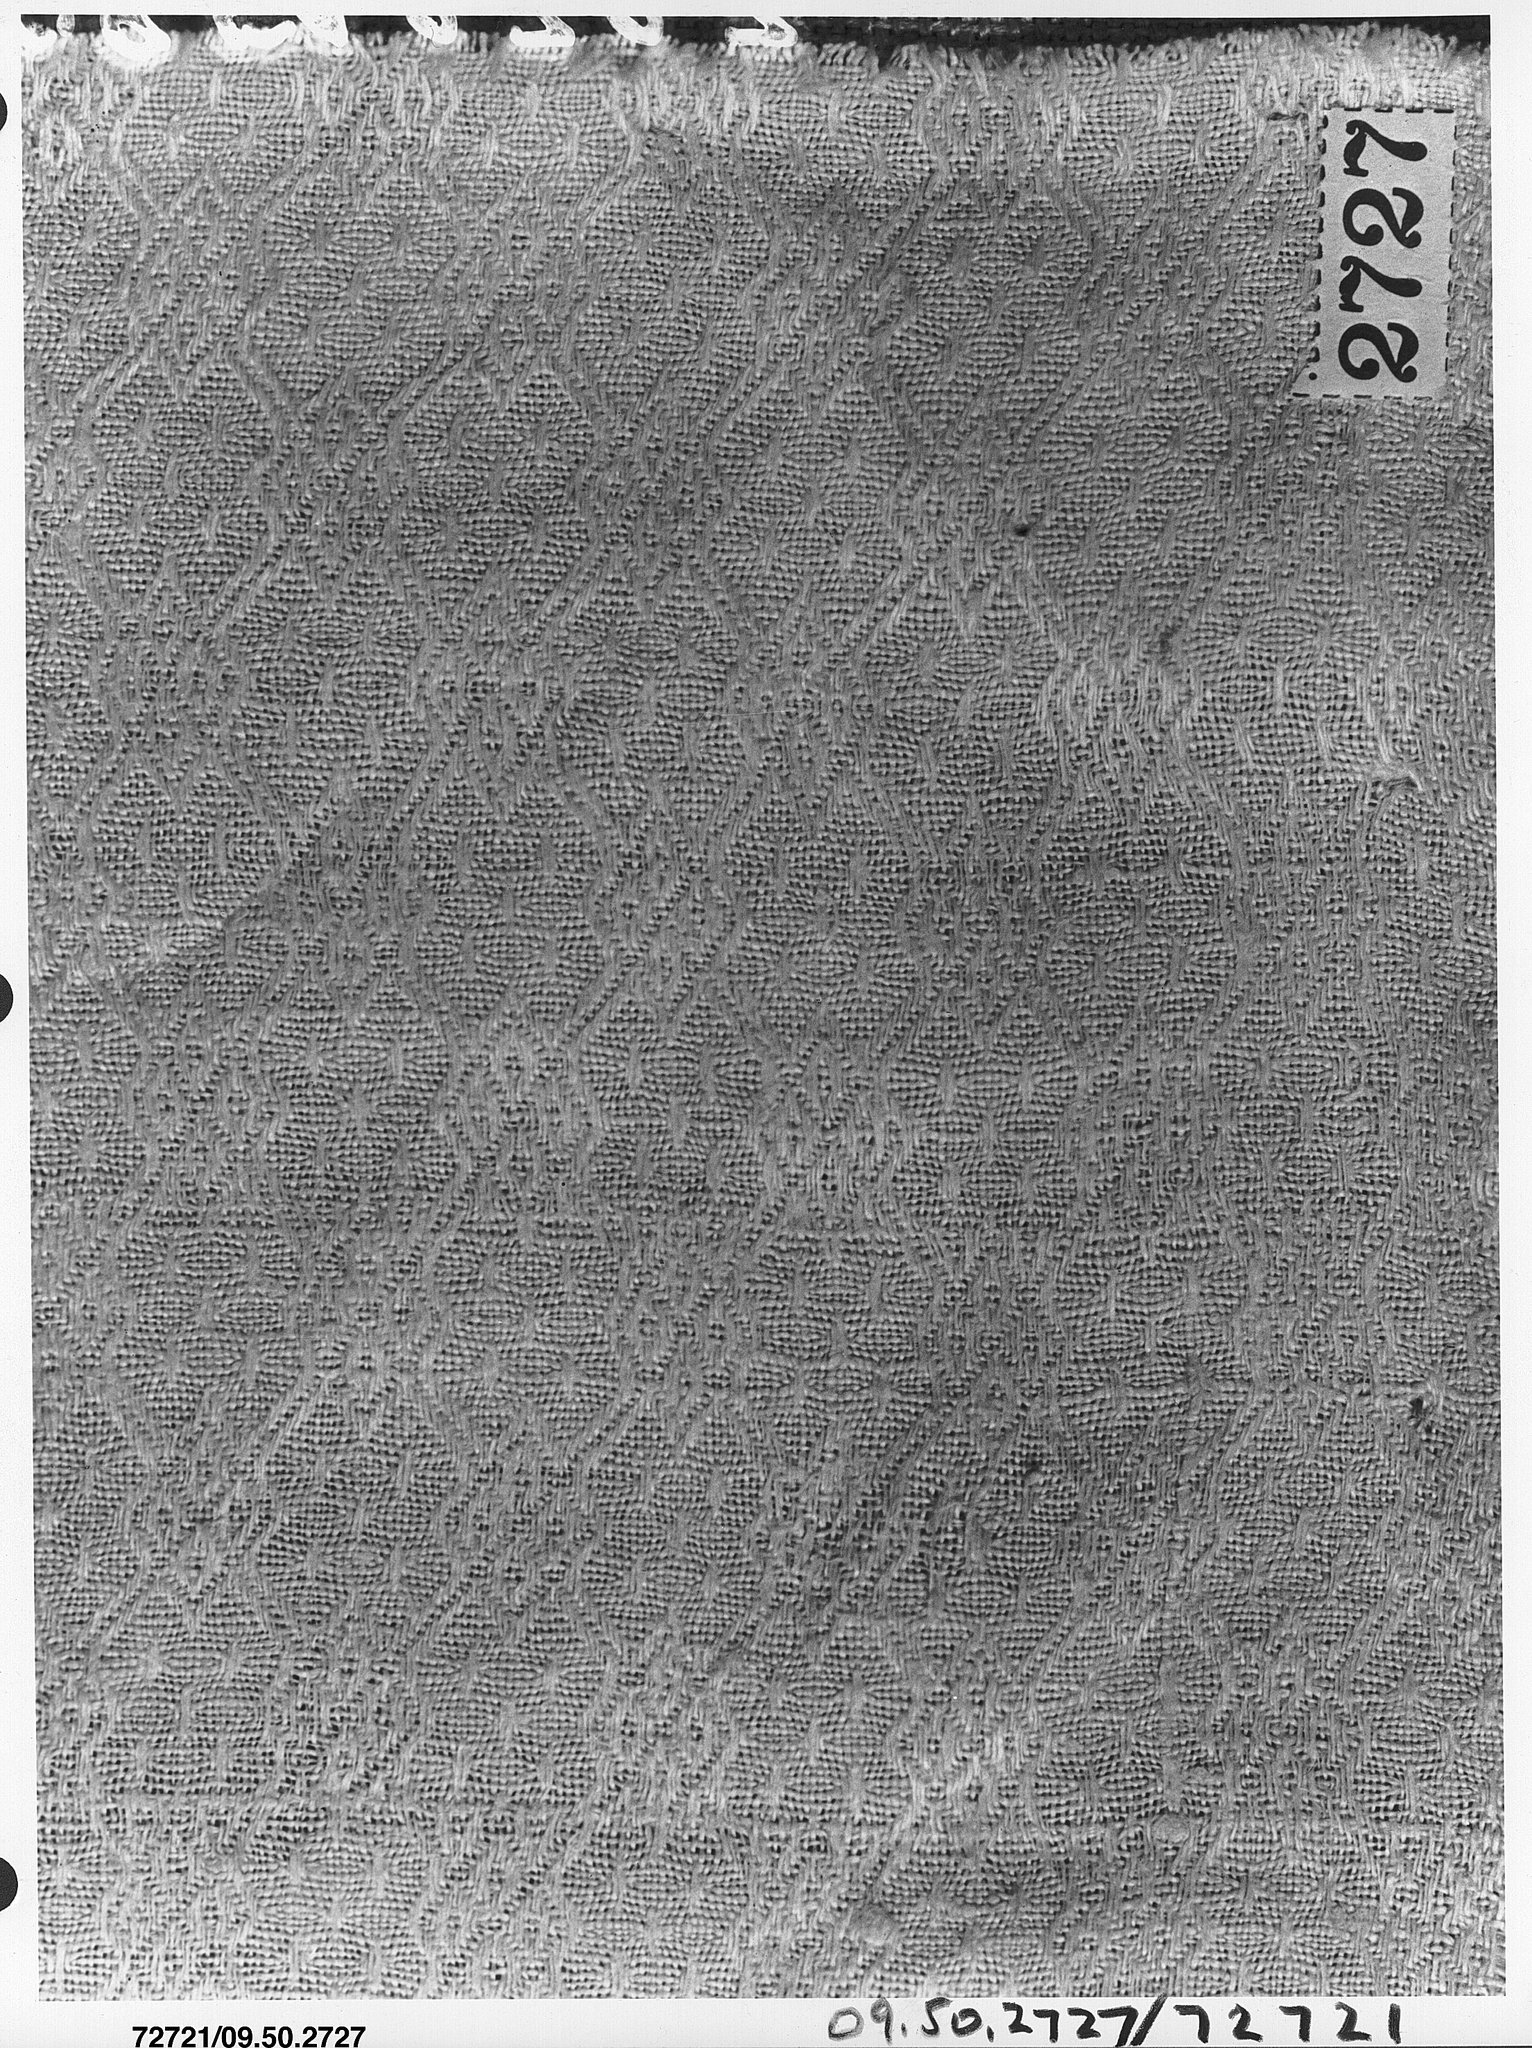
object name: piece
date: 1701-1900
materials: linen